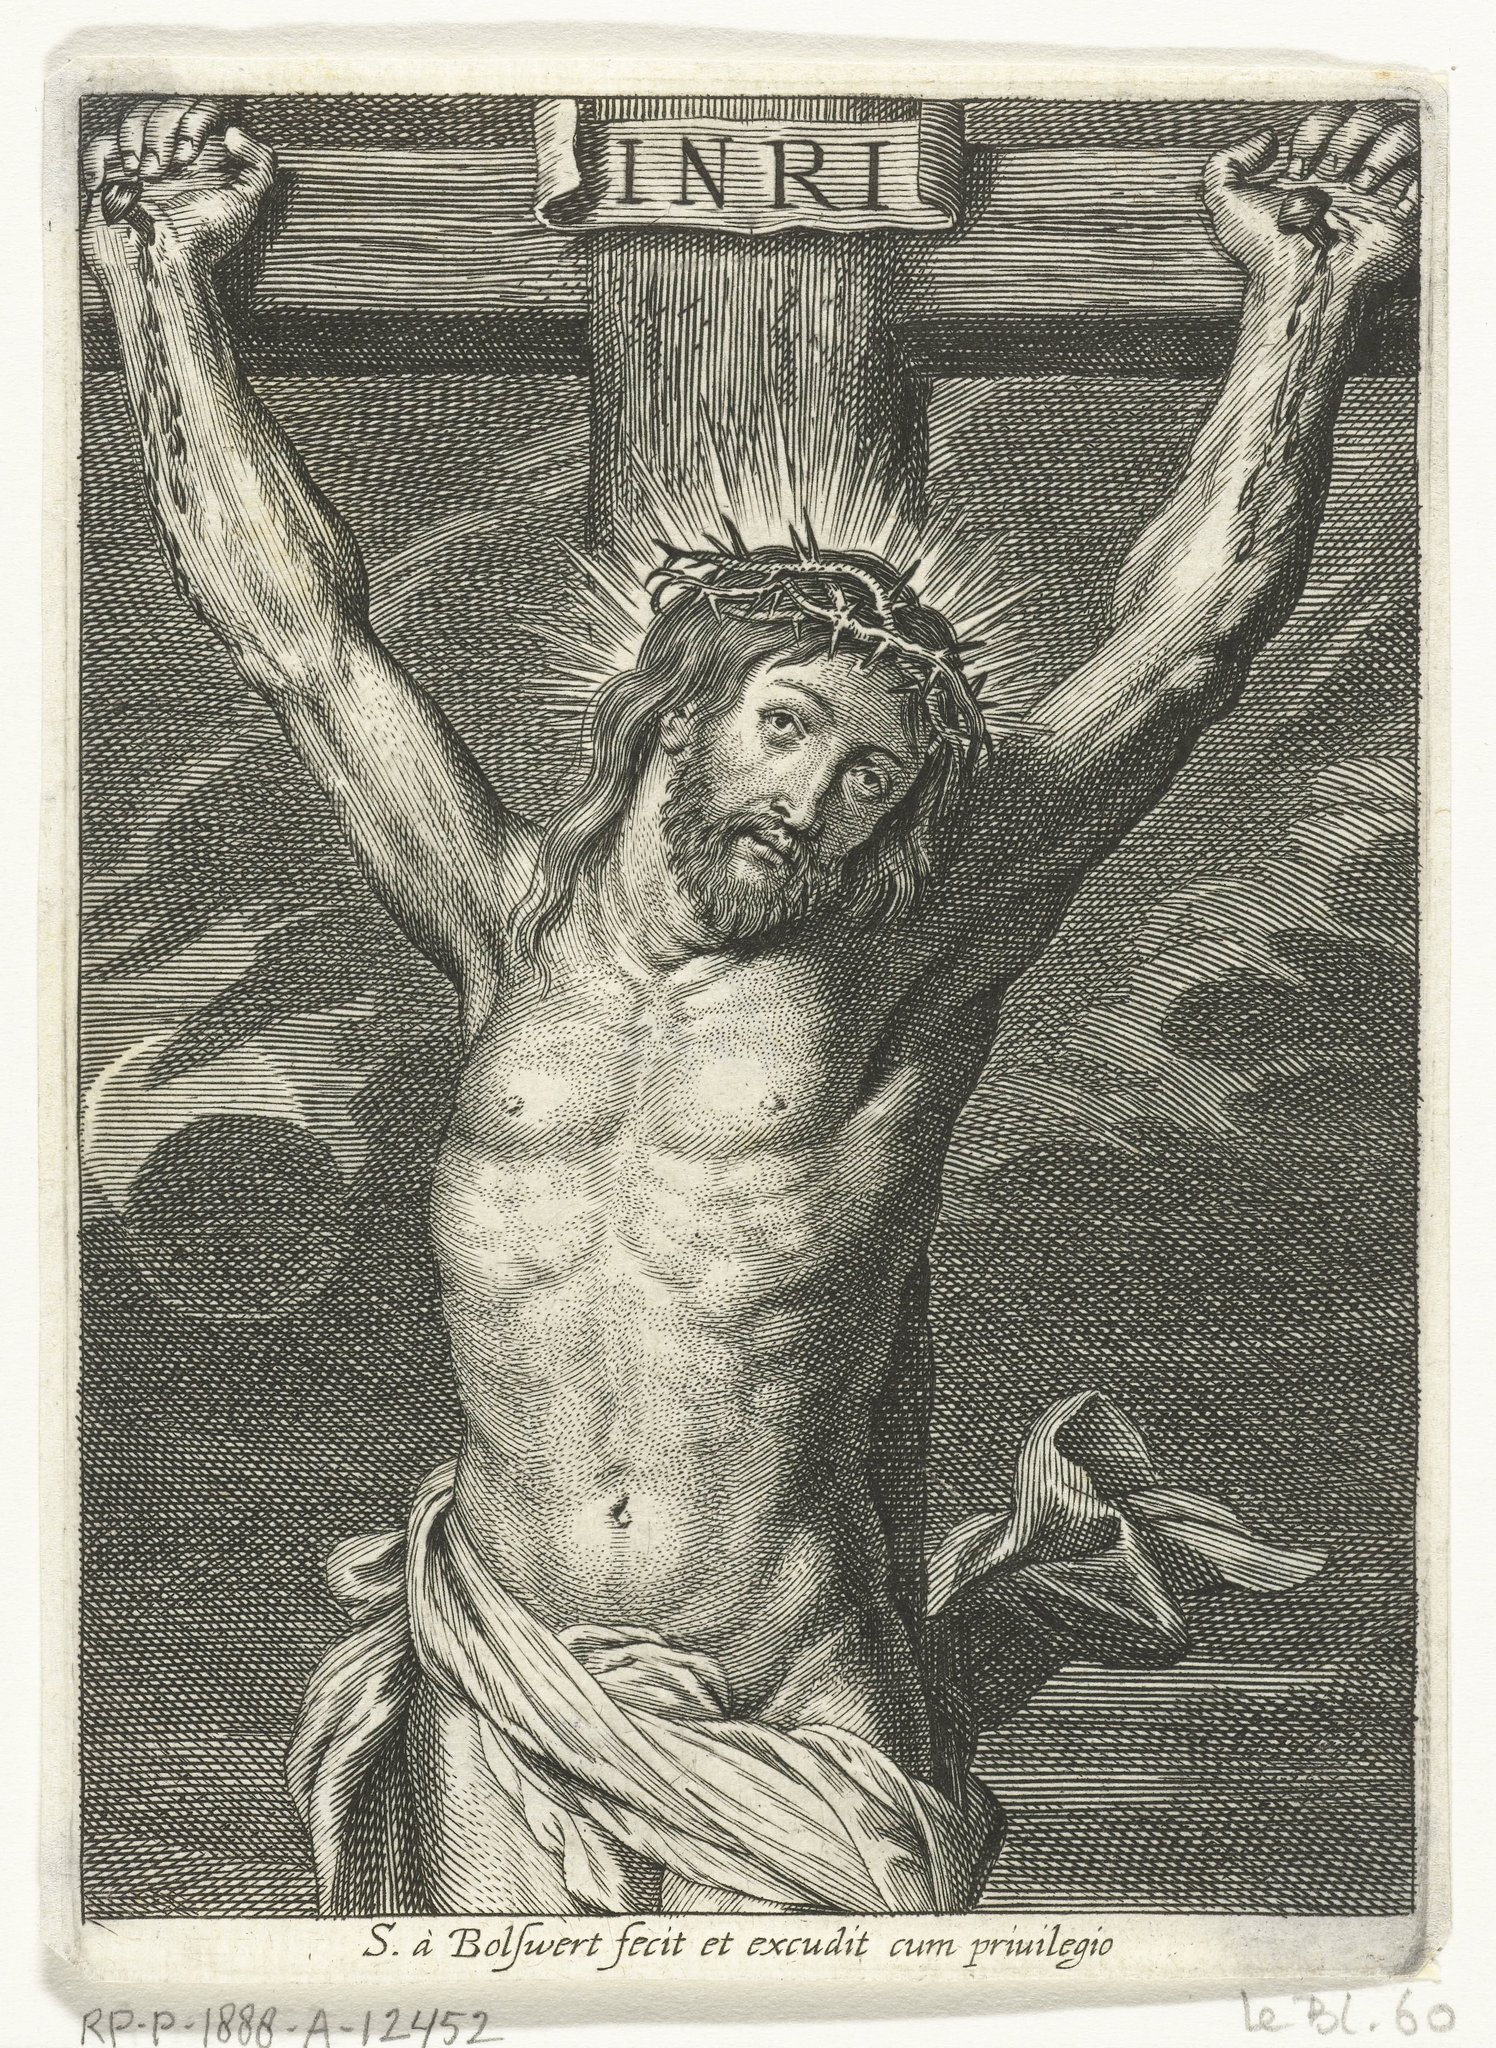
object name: print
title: Christus aan het kruis en zonsverduistering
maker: schelte adamsz. bolswert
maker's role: print maker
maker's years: 1586-1659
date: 1596-1659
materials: paper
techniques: engraving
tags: specific types of crucified christ (in non-narrative context), darkness from the sixth to the ninth hour (represented by a solar eclipse) ~ christ's death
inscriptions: collector's mark: Lugt 2228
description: Prent uit serie Vélins met negentig prenten naar ontwerp van Peter Paul Rubens. In de bronnen vinden we uiteenlopende gegevens over aantal en samenstelling van de serie. Hollstein hanteert het aantal van negentig prenten. De reeks Vélins in de collectie van het RMA bevat verschillende staten afkomstig uit meerdere uitgaven welke moeilijk te duiden zijn. Sommige dragen het originele adres van Schelte Adamsz. Bolswert als graveur en uitgever, op andere exemplaren is deze naam verwijderd (duidelijk zichtbaar!) en vervangen door de naam Cornelis Galle (II). De prenten met de naam van uitgever Galle zijn vaak opgewerkt. Herkomst uit meerdere uitgaven spreekt ook uit afwijkende opschriften in Nederlands en Latijn en variaties op dezelfde thema's welke misschien nooit langs elkaar in dezelfde serie gebruikt werden.